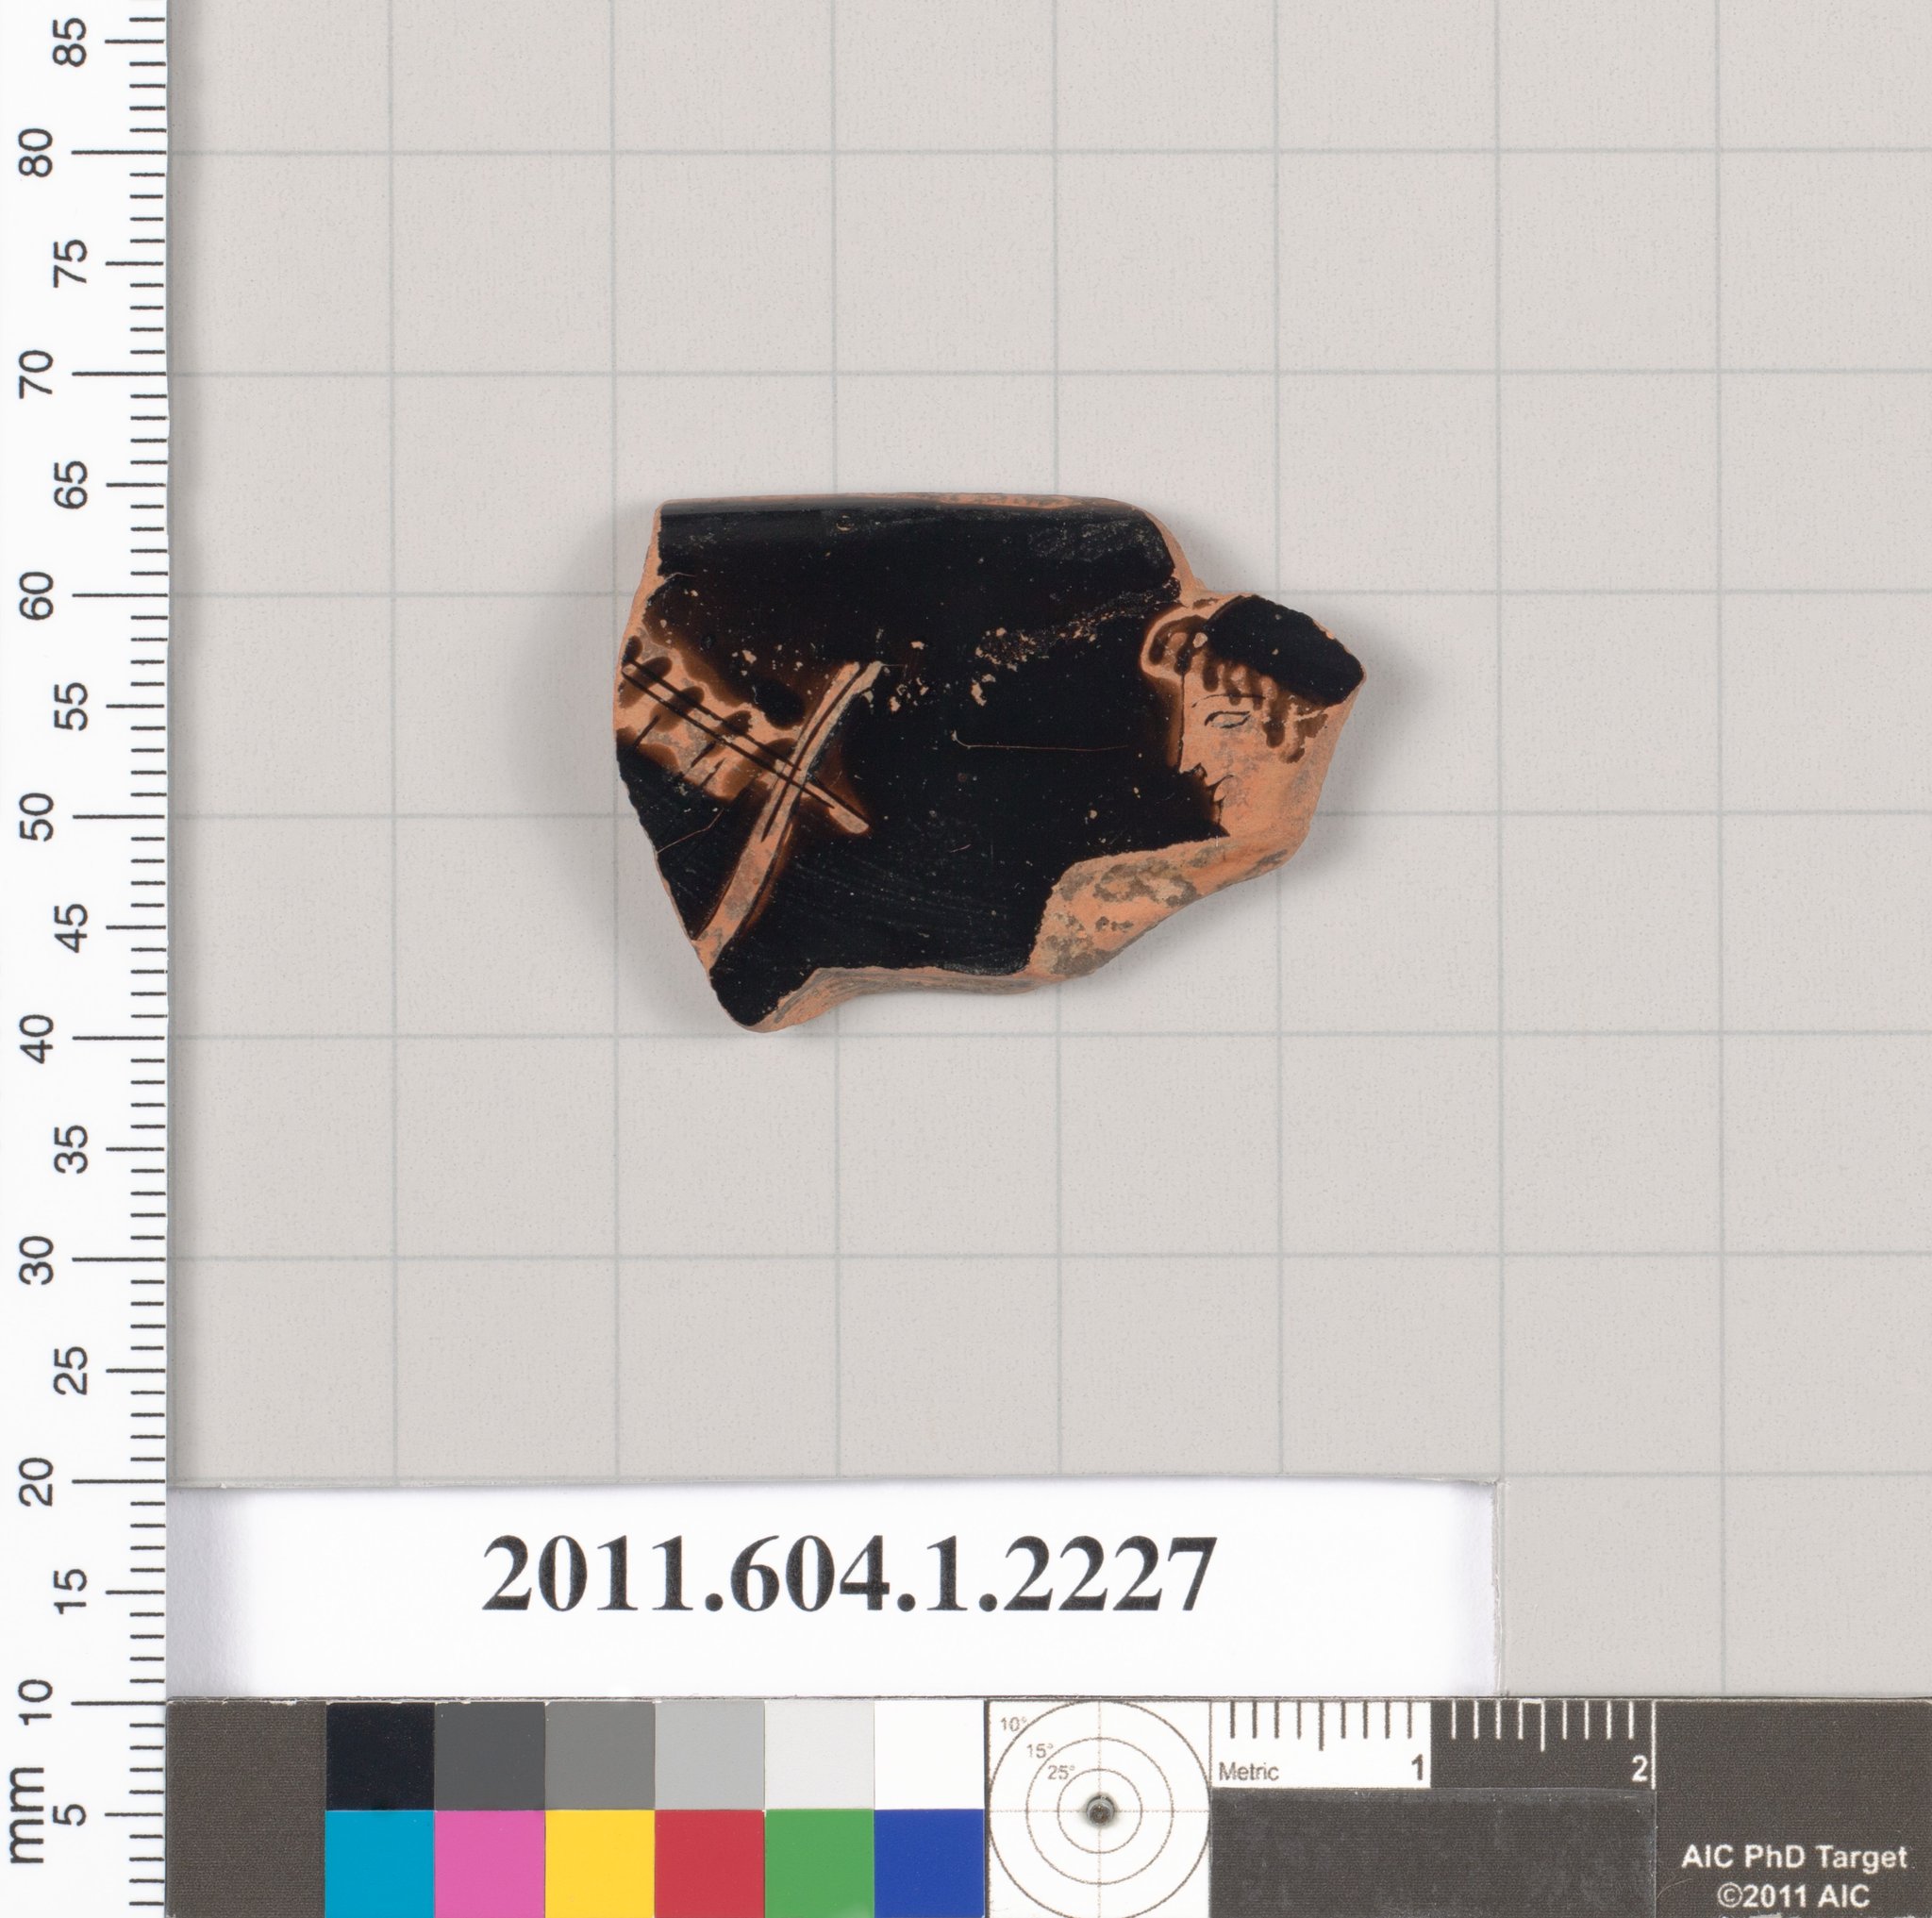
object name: kylix fragment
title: Terracotta rim fragment of a kylix (drinking cup)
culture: greek, attic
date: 475-451 BCE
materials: terracotta